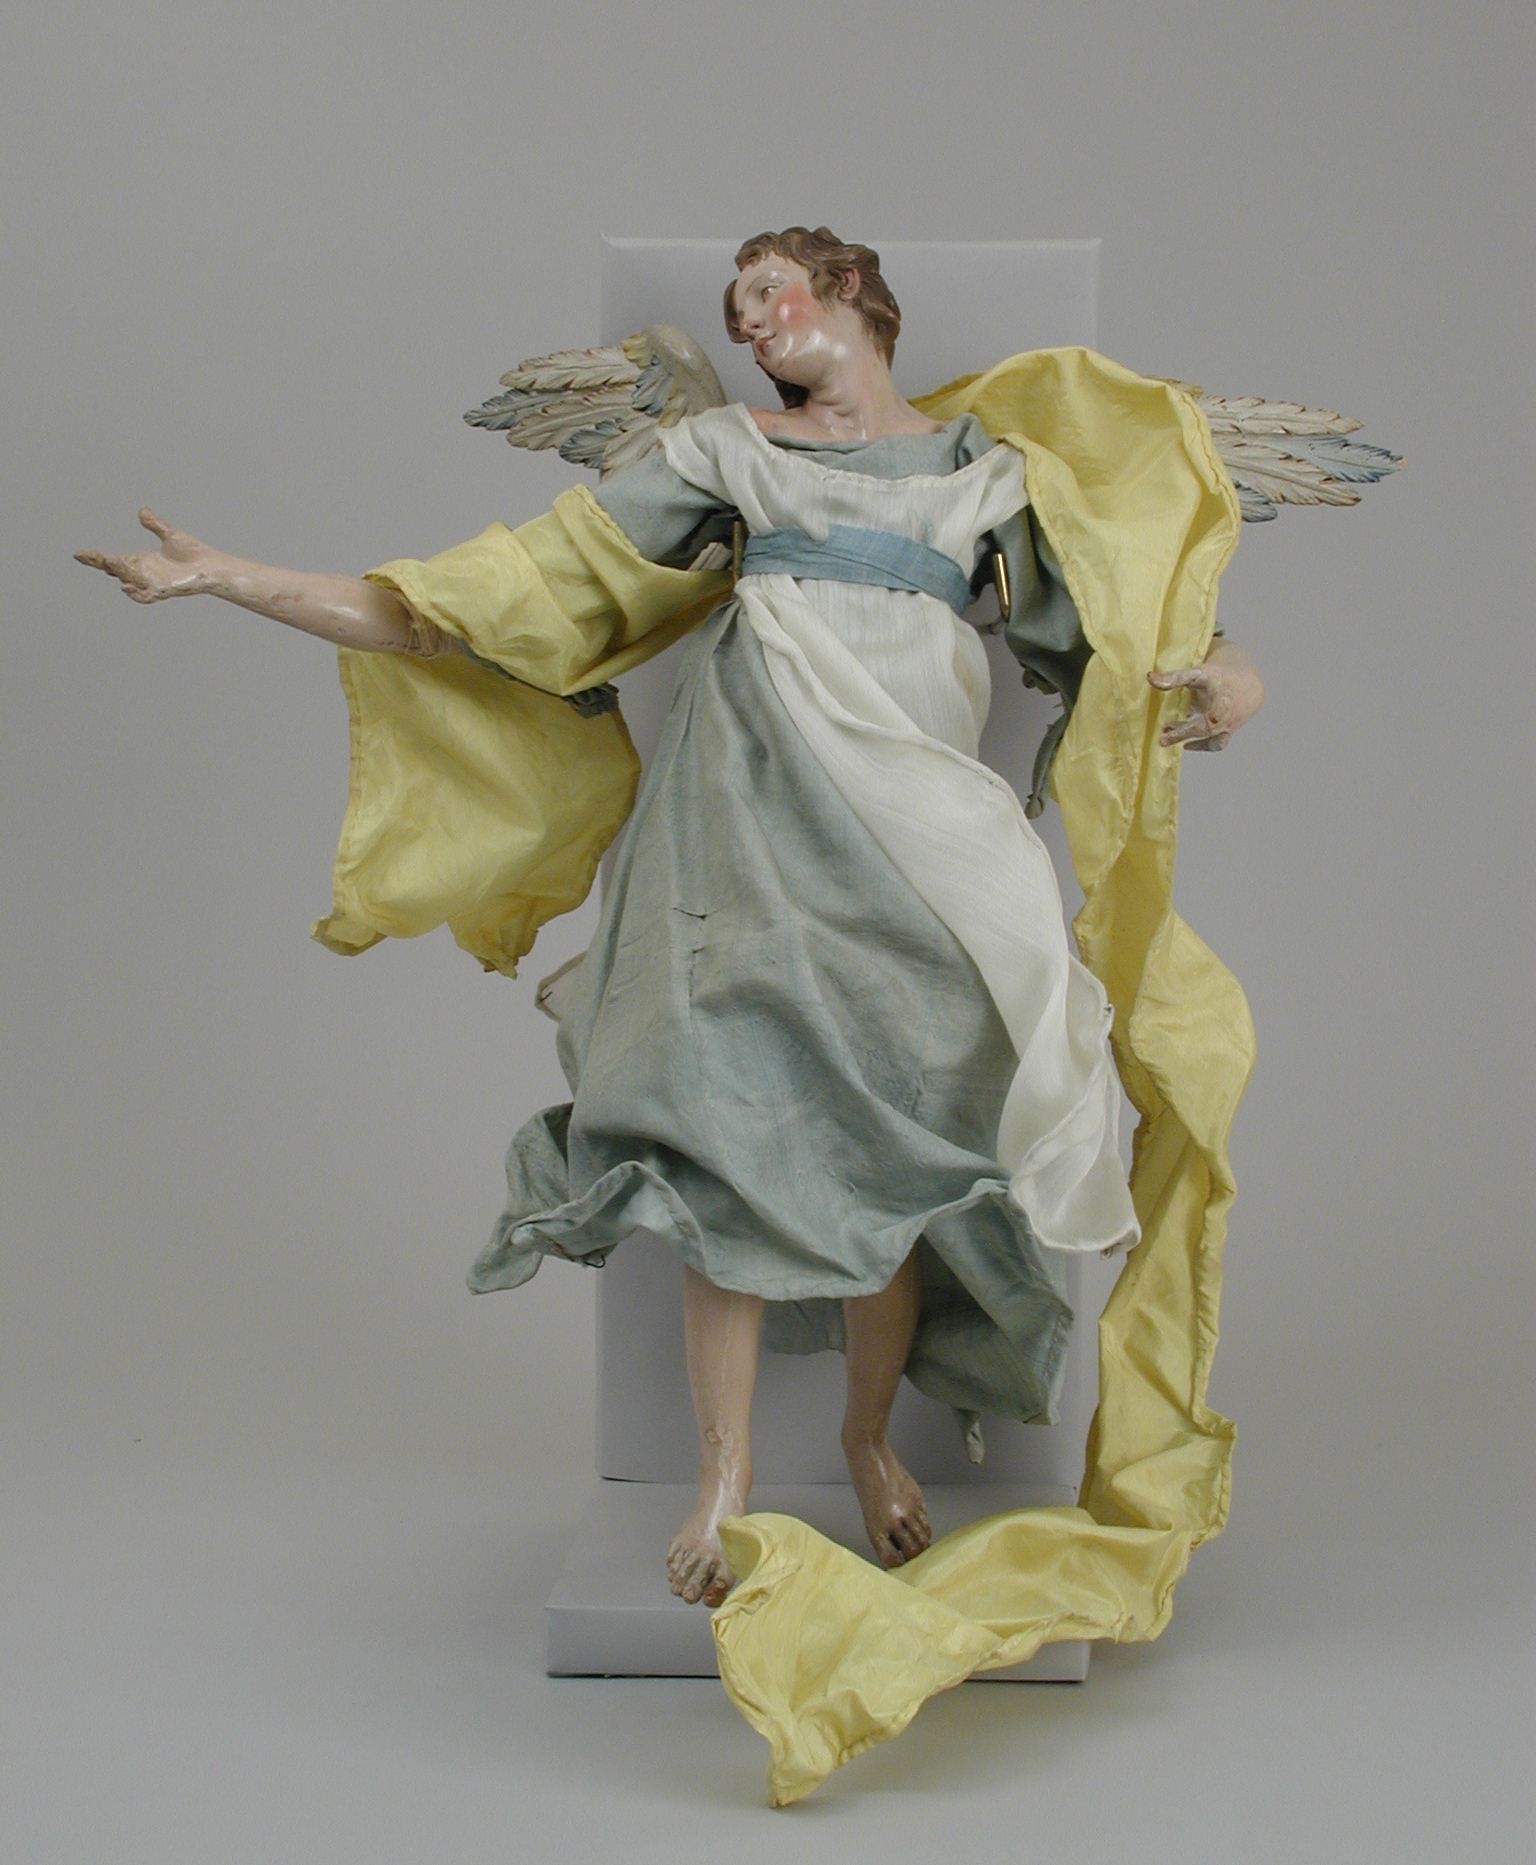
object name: crèche figure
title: Angel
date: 1751-1800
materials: terracotta, fiber, metal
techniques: polychrome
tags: angels